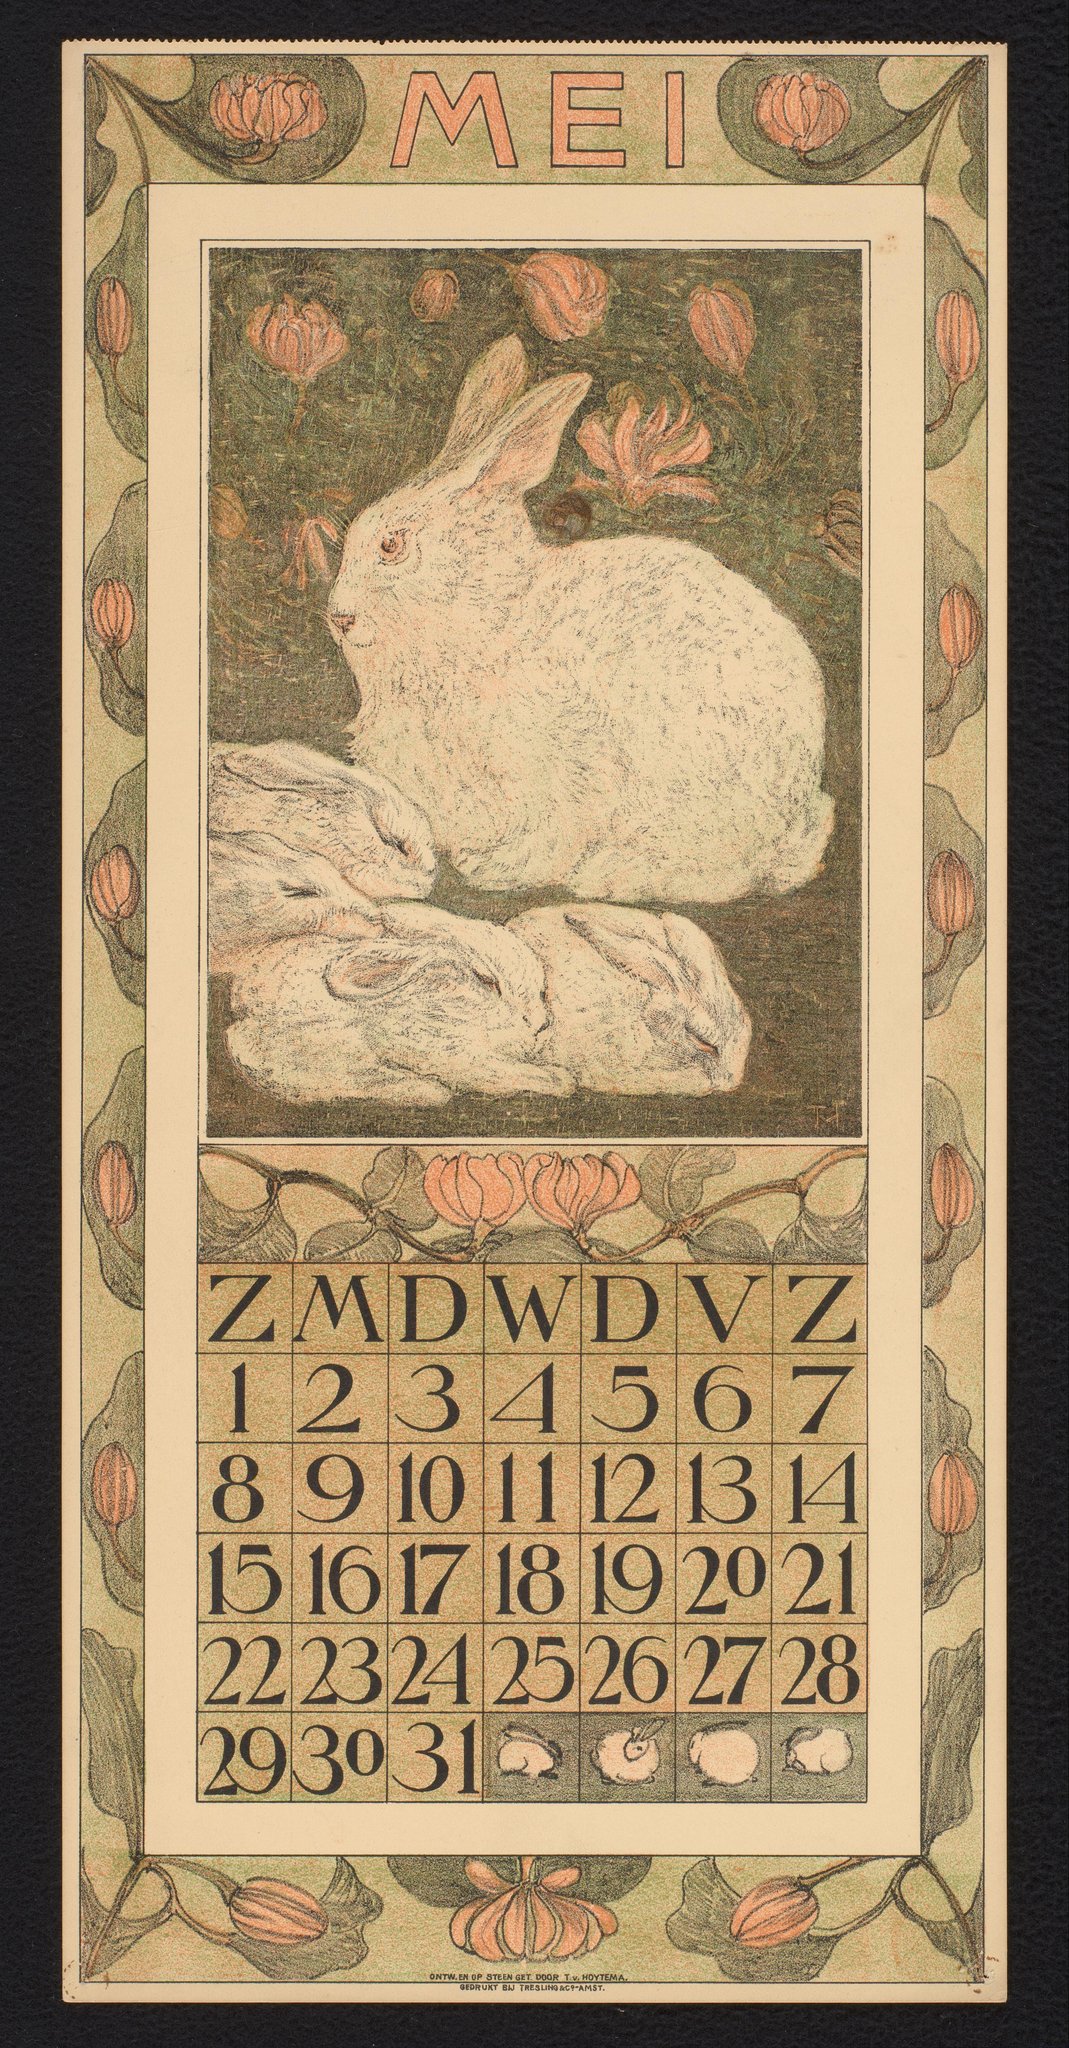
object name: print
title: Kalenderblad voor mei 1910 met een wit konijn met vier jongen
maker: theo van hoytema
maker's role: draughtsman, painter, print maker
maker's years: 1863-1917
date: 1909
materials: paper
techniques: lithograph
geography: amsterdam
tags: calendar, almanac, rodents: rabbit